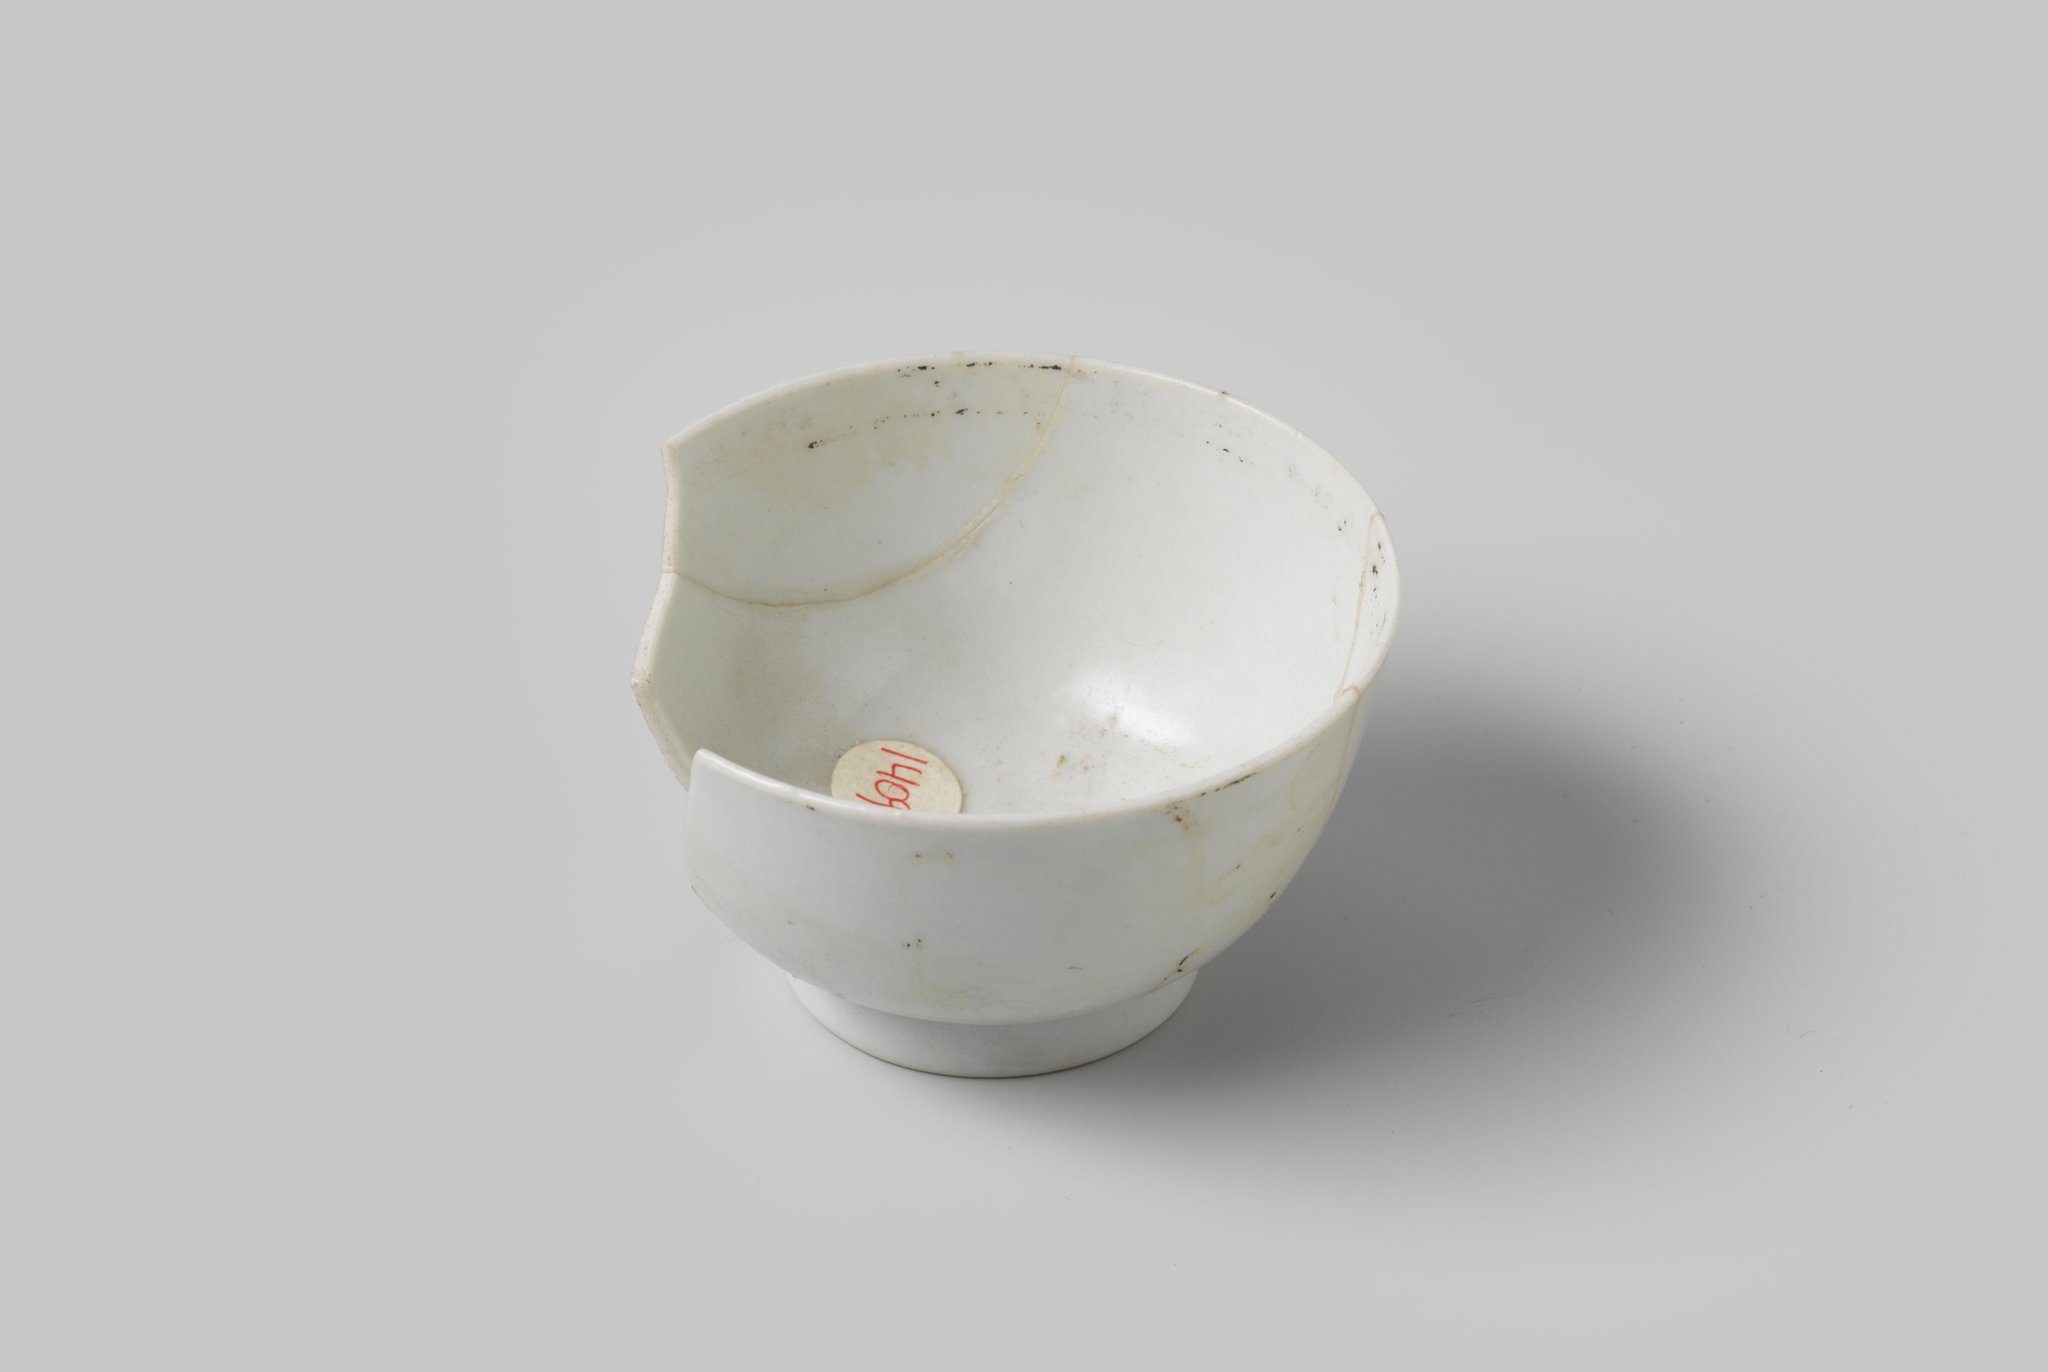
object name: bowl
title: Kom, gevonden bij V.O.C.-schip Witte Leeuw, mogelijk afkomstig van Zeelelie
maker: Anonymous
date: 1775-1800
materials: porcelain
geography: guangdong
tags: verenigde oostindische compagnie, sint-helena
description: Kom, bestaande uit vier aan elkaar gelijmde fragmenten, gevonden bij V.O.C.-schip de 'Witte Leeuw', 80% aanwezig. Dit object is 18e-eeuws en kan dus niet van de vracht van de Witte Leeuw zijn. Onduidelijk is of het object van de site komt of dat het later is vermengd, mogelijk met materiaal van de Zeelelie.